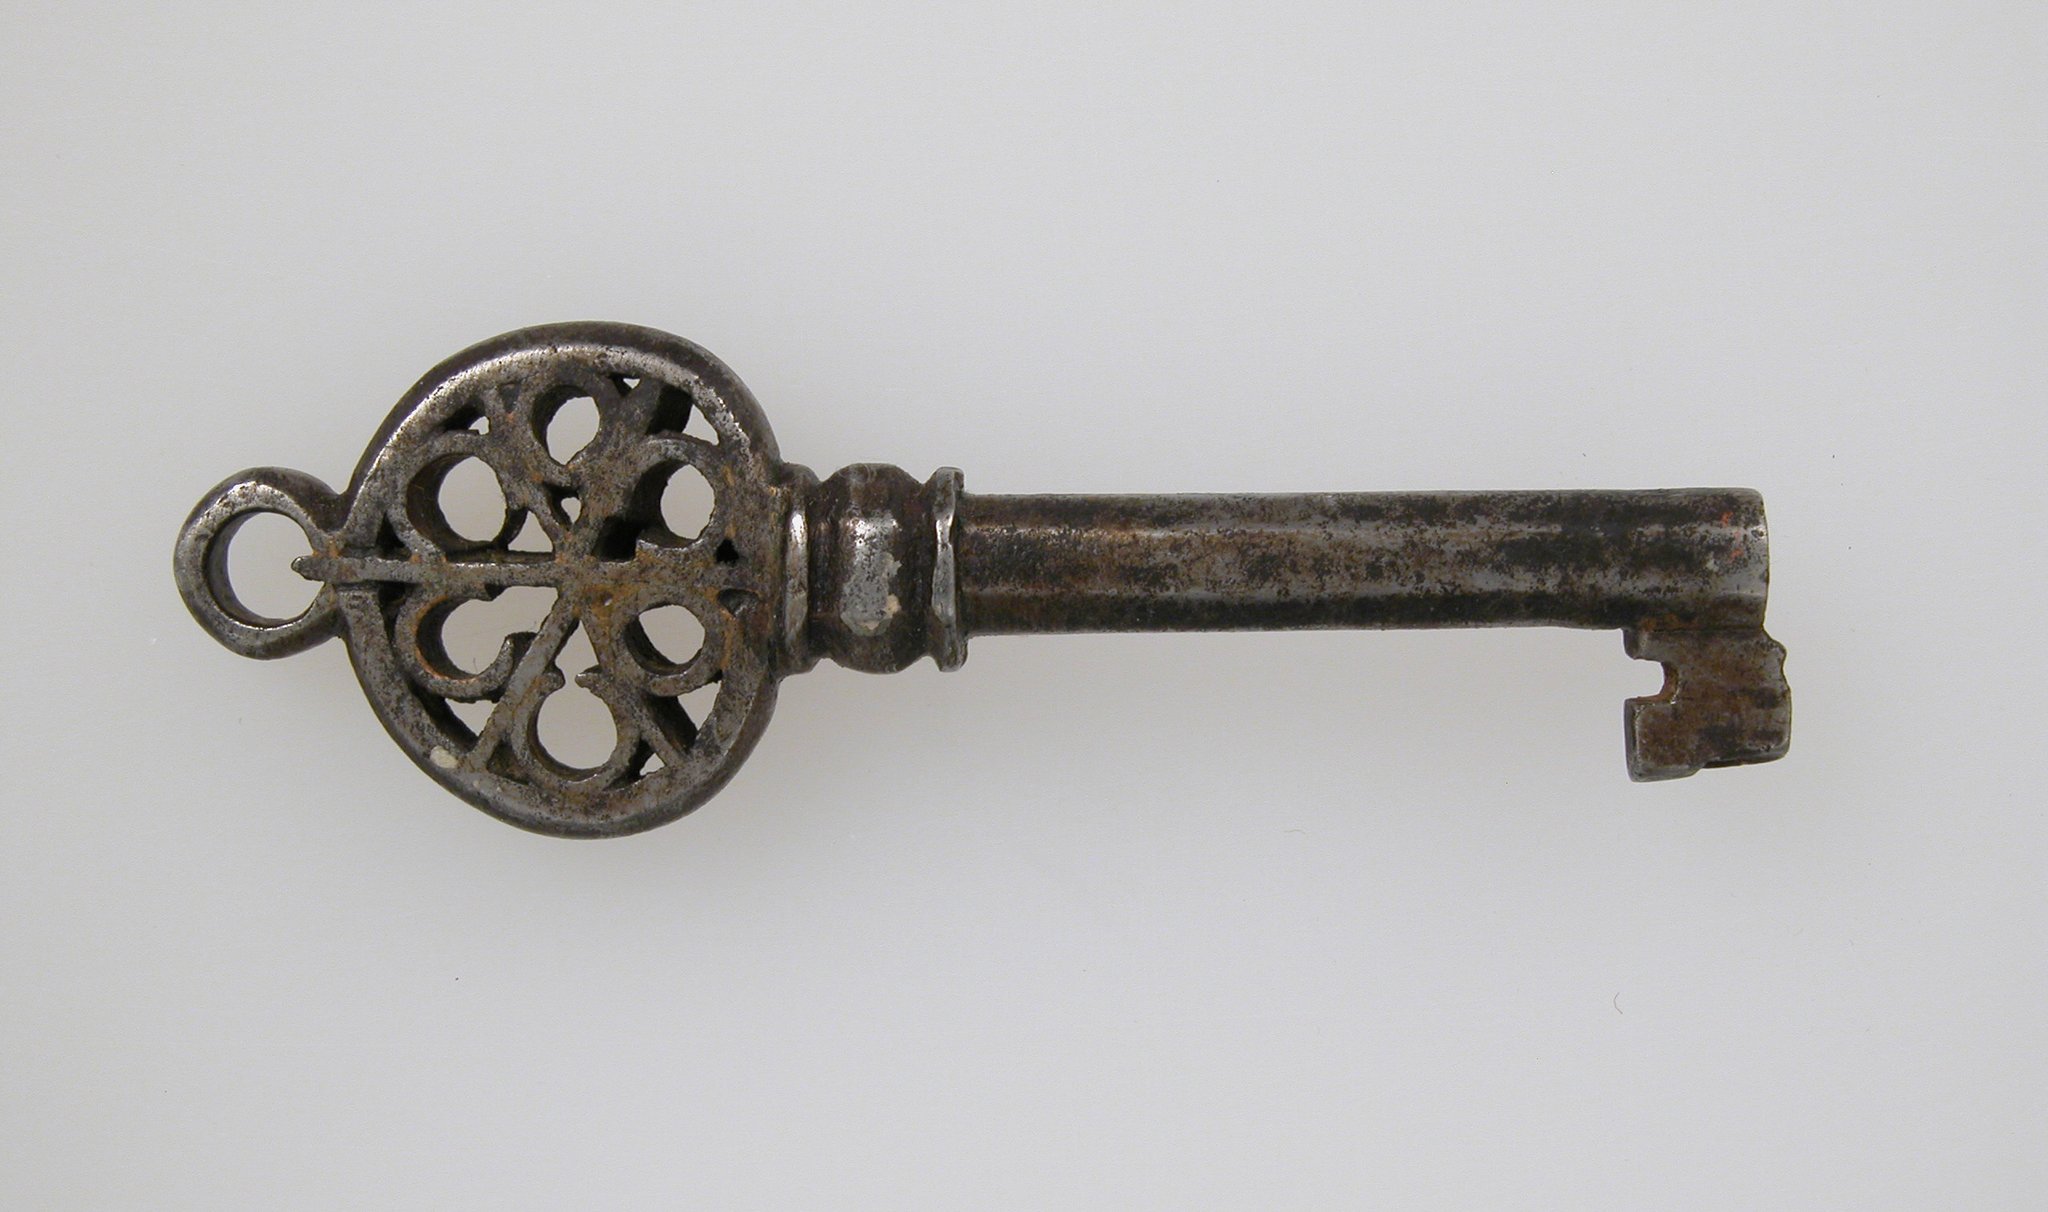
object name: key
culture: german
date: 1401-1500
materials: iron